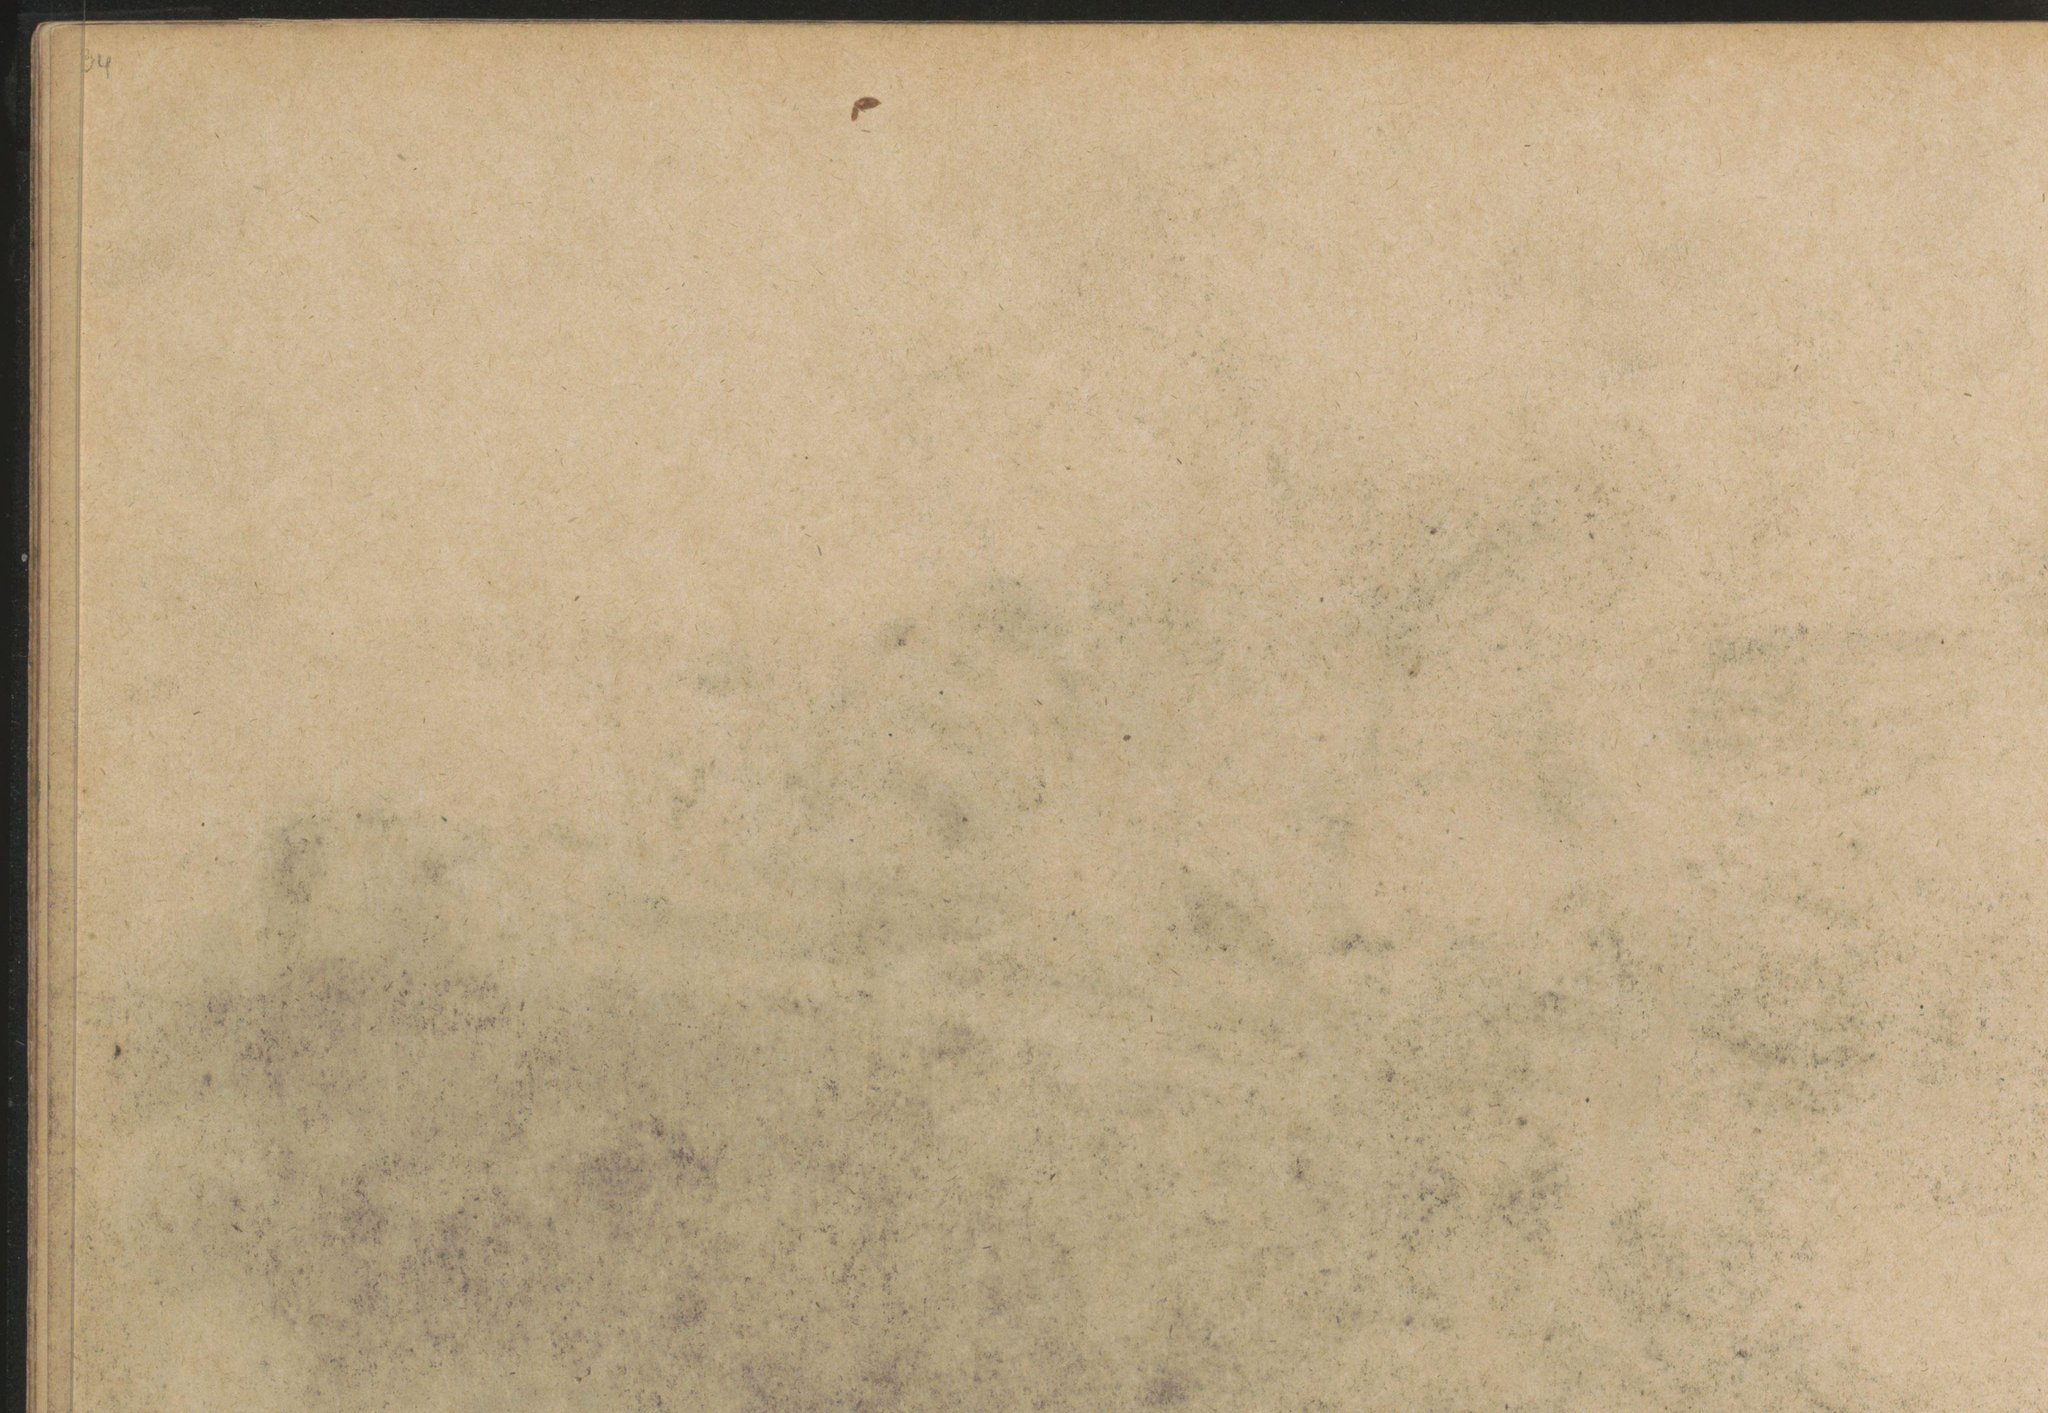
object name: sketchbook leaf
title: Abklatsch van de krijttekening op pagina 35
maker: willem witsen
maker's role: draughtsman, painter, print maker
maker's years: 1860-1923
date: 1882-1884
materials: paper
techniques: printmaking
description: Pagina 34 uit een schetsboek met 19 bladen.